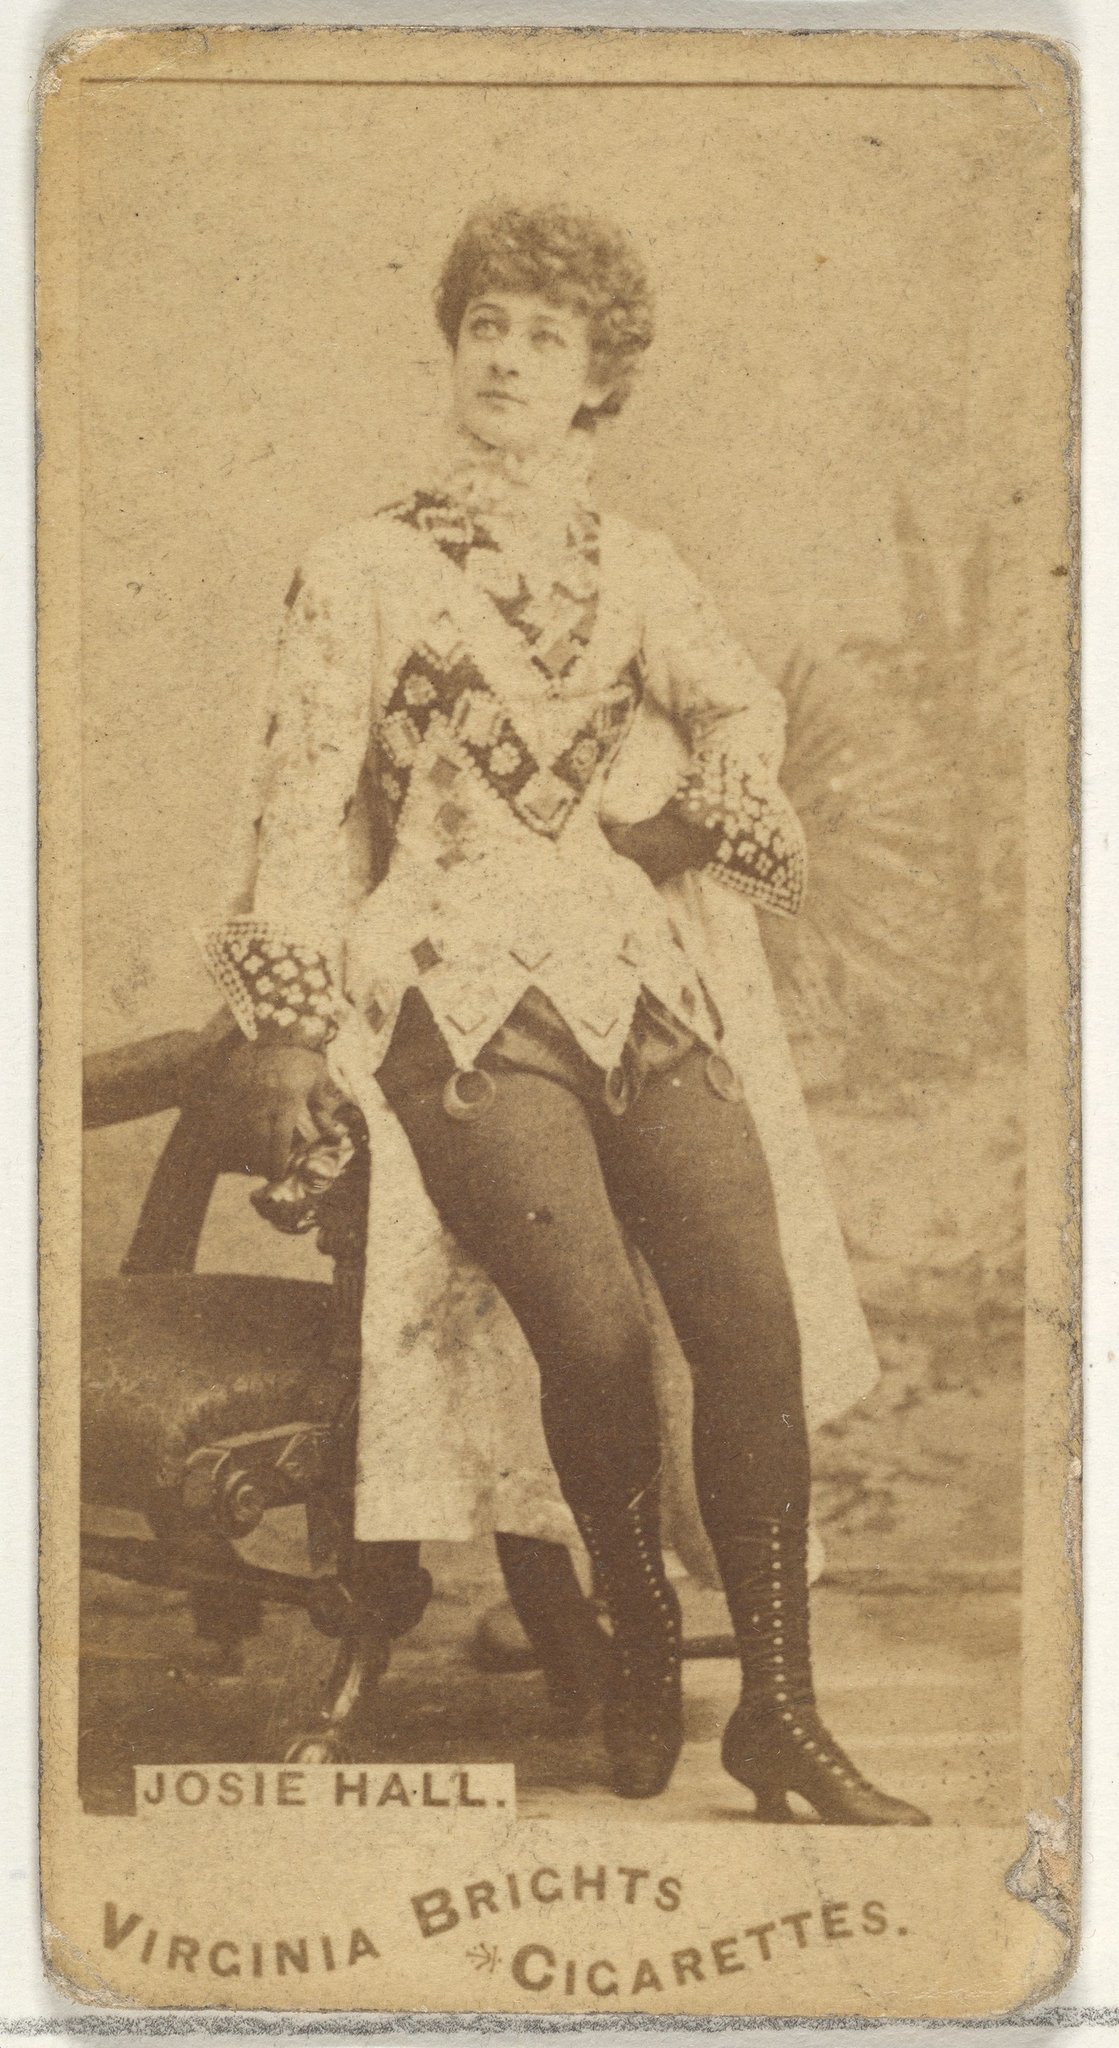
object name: photograph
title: Josie Hall, from the Actors and Actresses series (N45, Type 1) for Virginia Brights Cigarettes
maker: allen & ginter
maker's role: publisher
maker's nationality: american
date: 1888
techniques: albumen silver print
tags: portraits,women,actresses